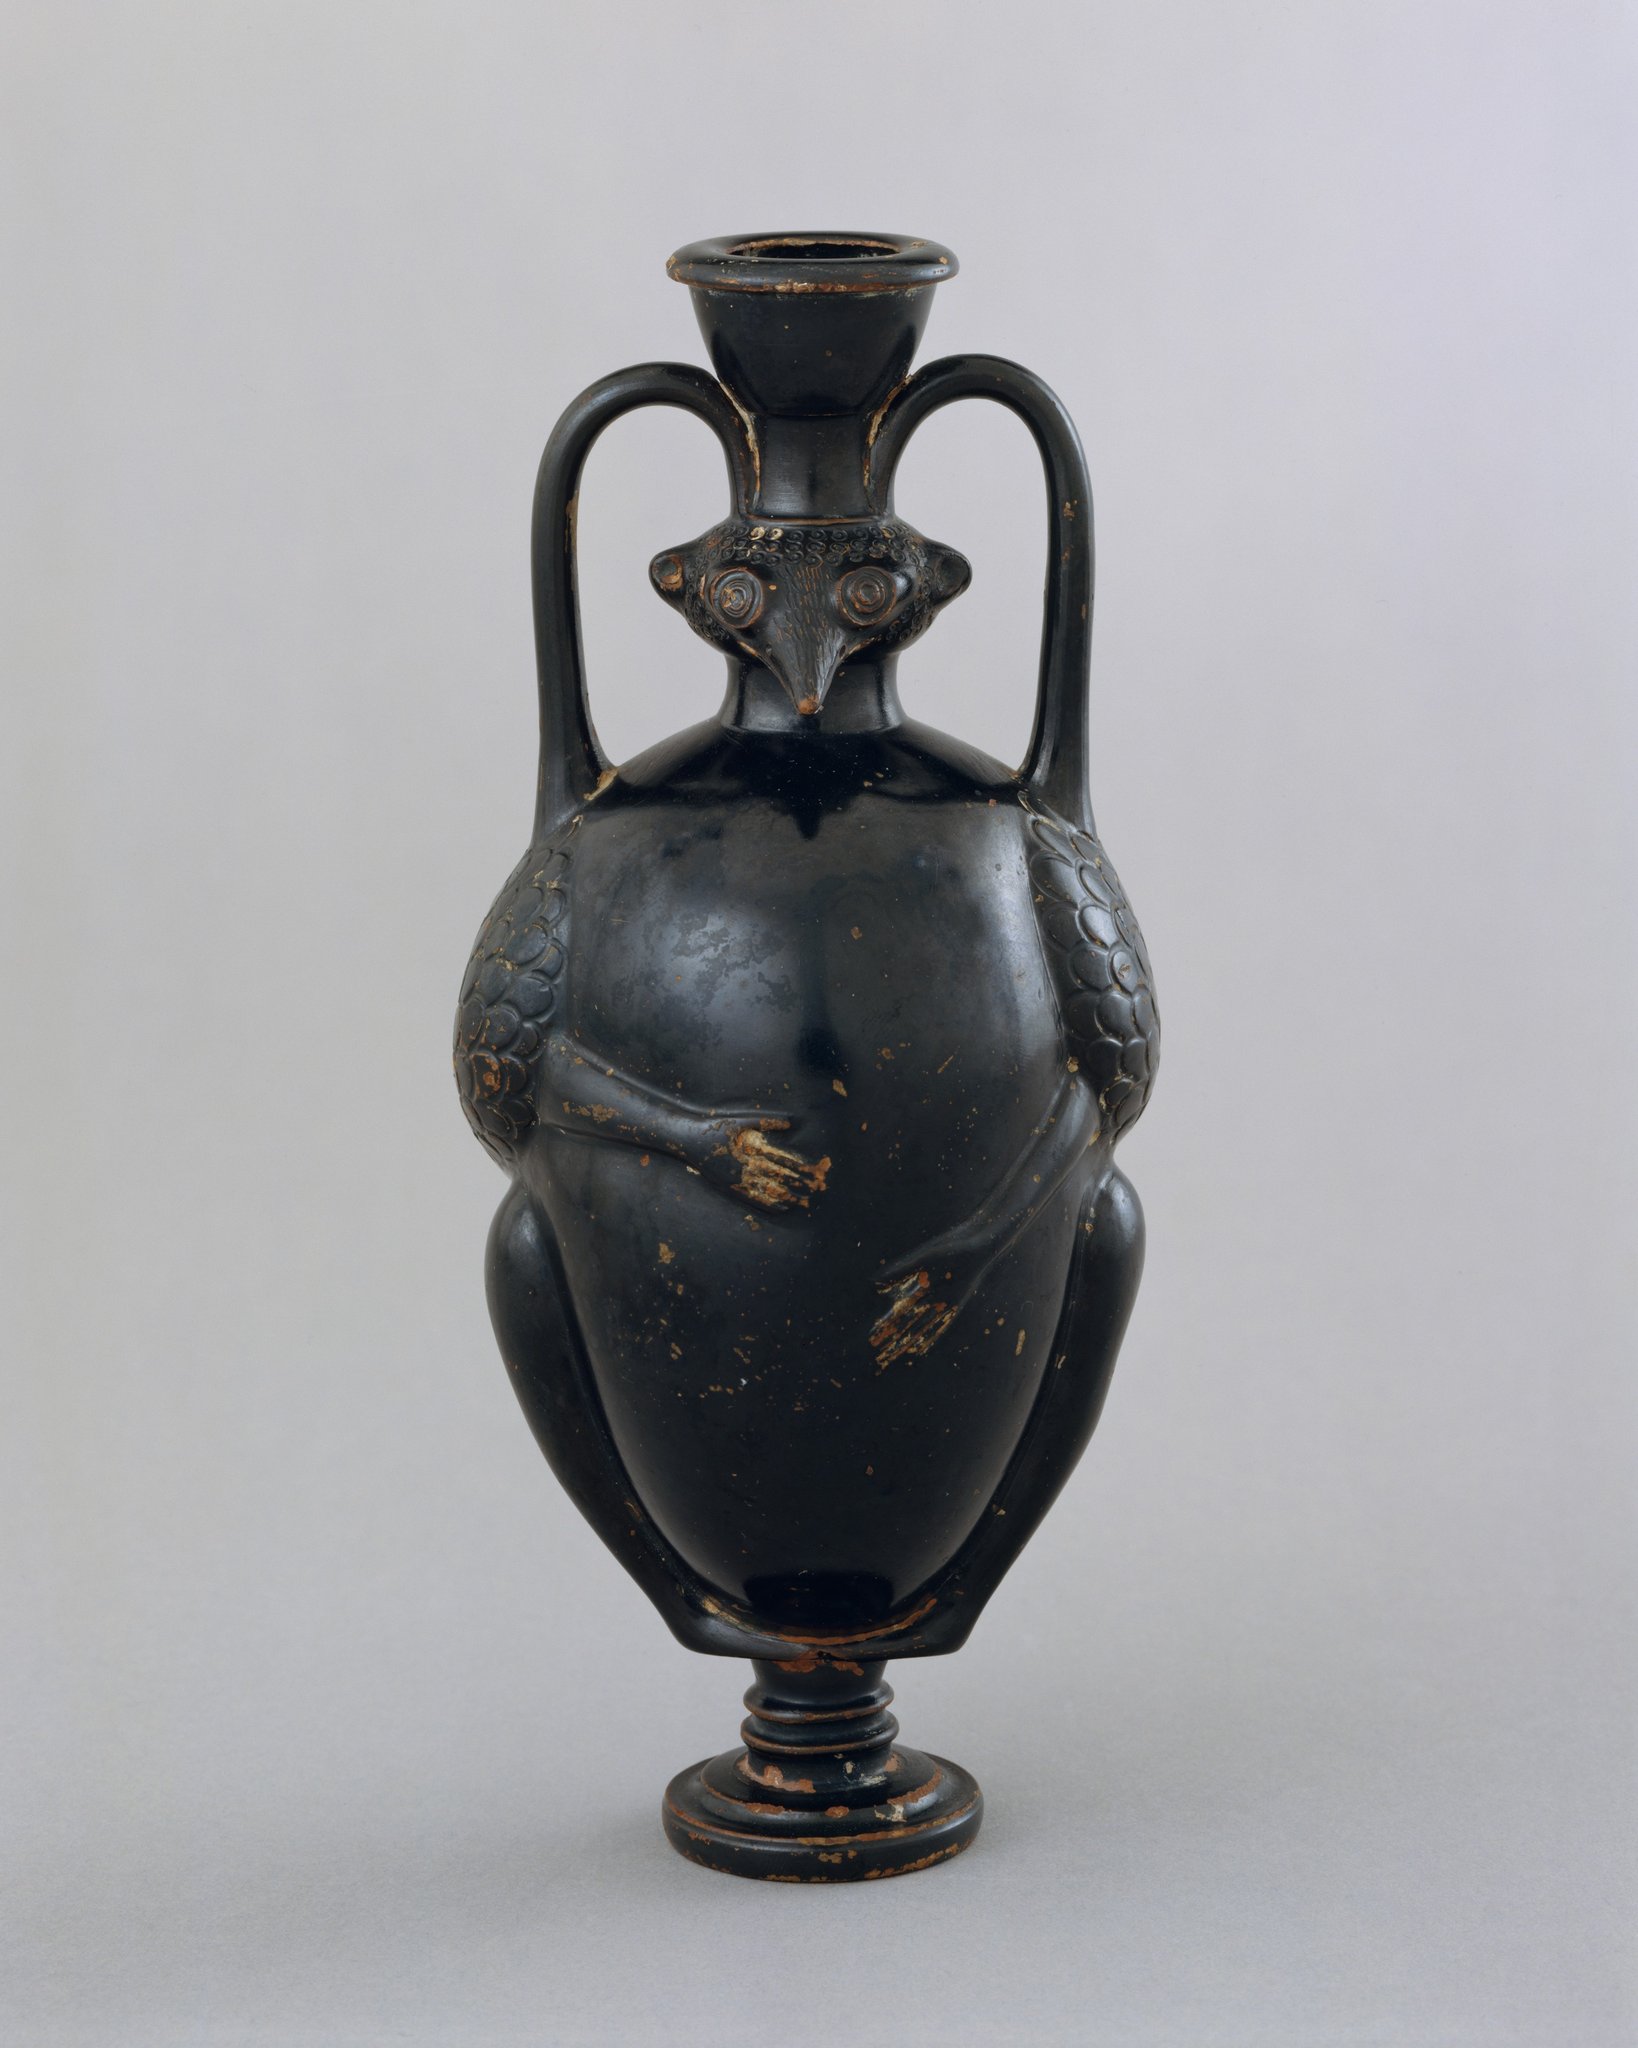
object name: amphoriskos in the form of a bird man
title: Terracotta amphoriskos (flask) in the form of a bird-man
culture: greek, attic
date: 434-401 BCE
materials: terracotta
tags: birds